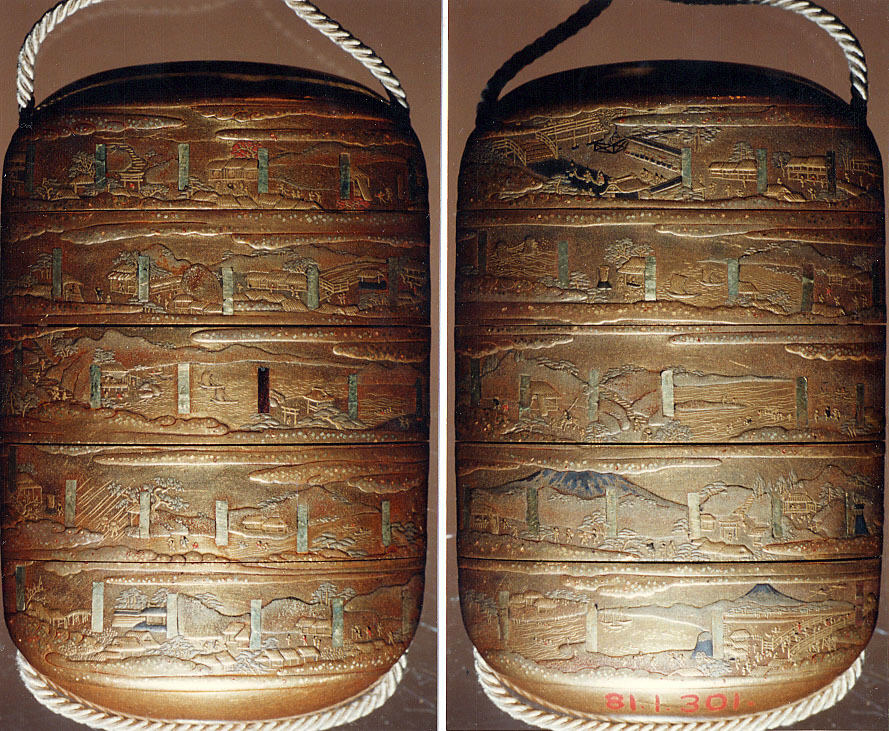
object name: inrō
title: Case (Inrō) with Design of Fifty-Three Stations of the Tokaidō in Japan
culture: japanese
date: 1801-1900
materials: gold, gold foil, lacquer, silver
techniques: fundame, hiramakie, maki-e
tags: landscapes,boats